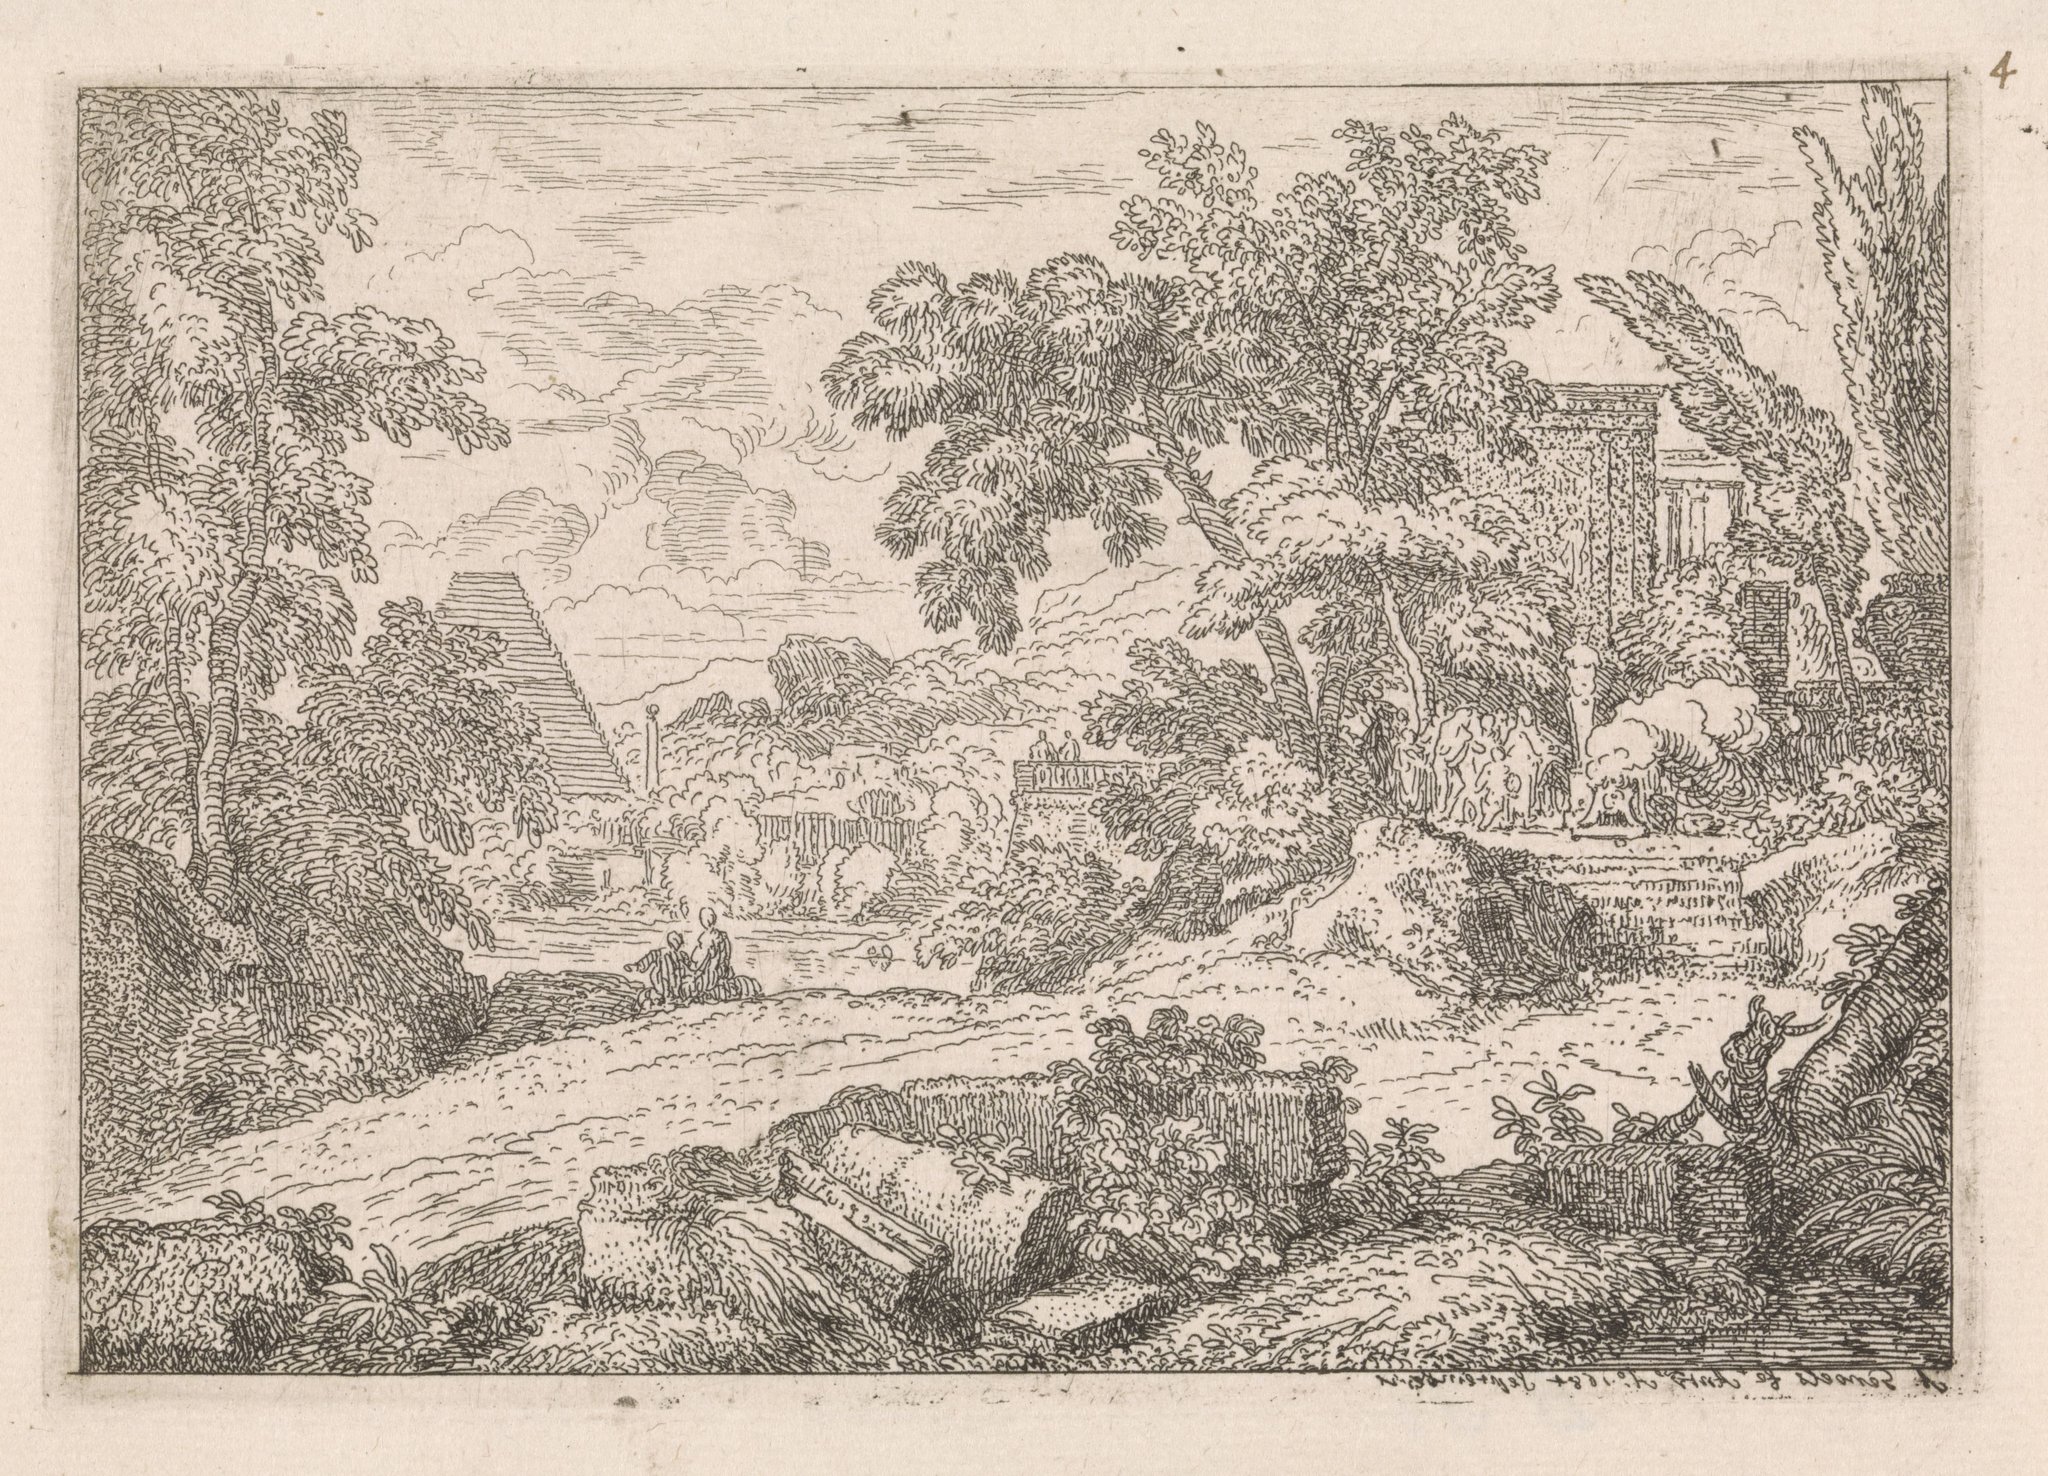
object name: print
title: Arcadisch landschap met tempeloffer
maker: abraham genoels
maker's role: draughtsman, print maker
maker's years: 1640-1723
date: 1684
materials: paper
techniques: etching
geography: antwerp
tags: temple, shrine ~ roman religion, pastorals, arcadian scenes, animal sacrifice ~ non-christian religions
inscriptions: collector's mark: Lugt 240, number: ‘4’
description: Een arcadisch landschap met rechts een tempel waarbij een vuuroffer wordt gebracht. De prent is deel van een serie met klassieke landschappen als thema.